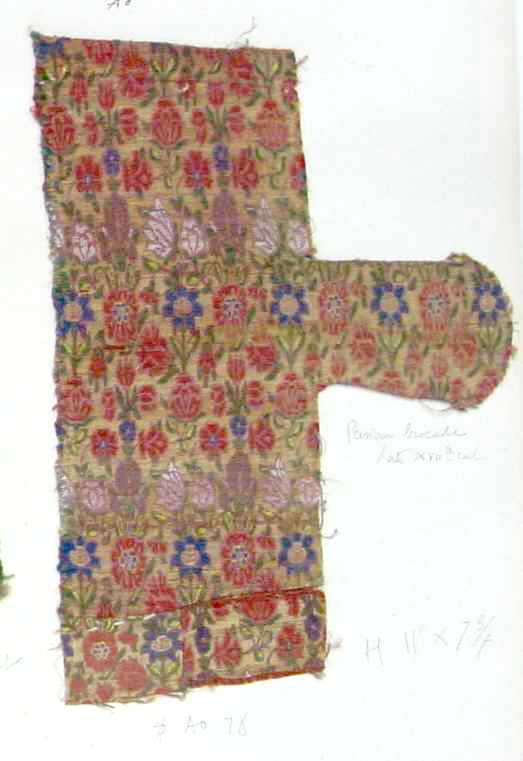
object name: textile fragment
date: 1601-1800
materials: metal thread, silk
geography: iran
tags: flowers